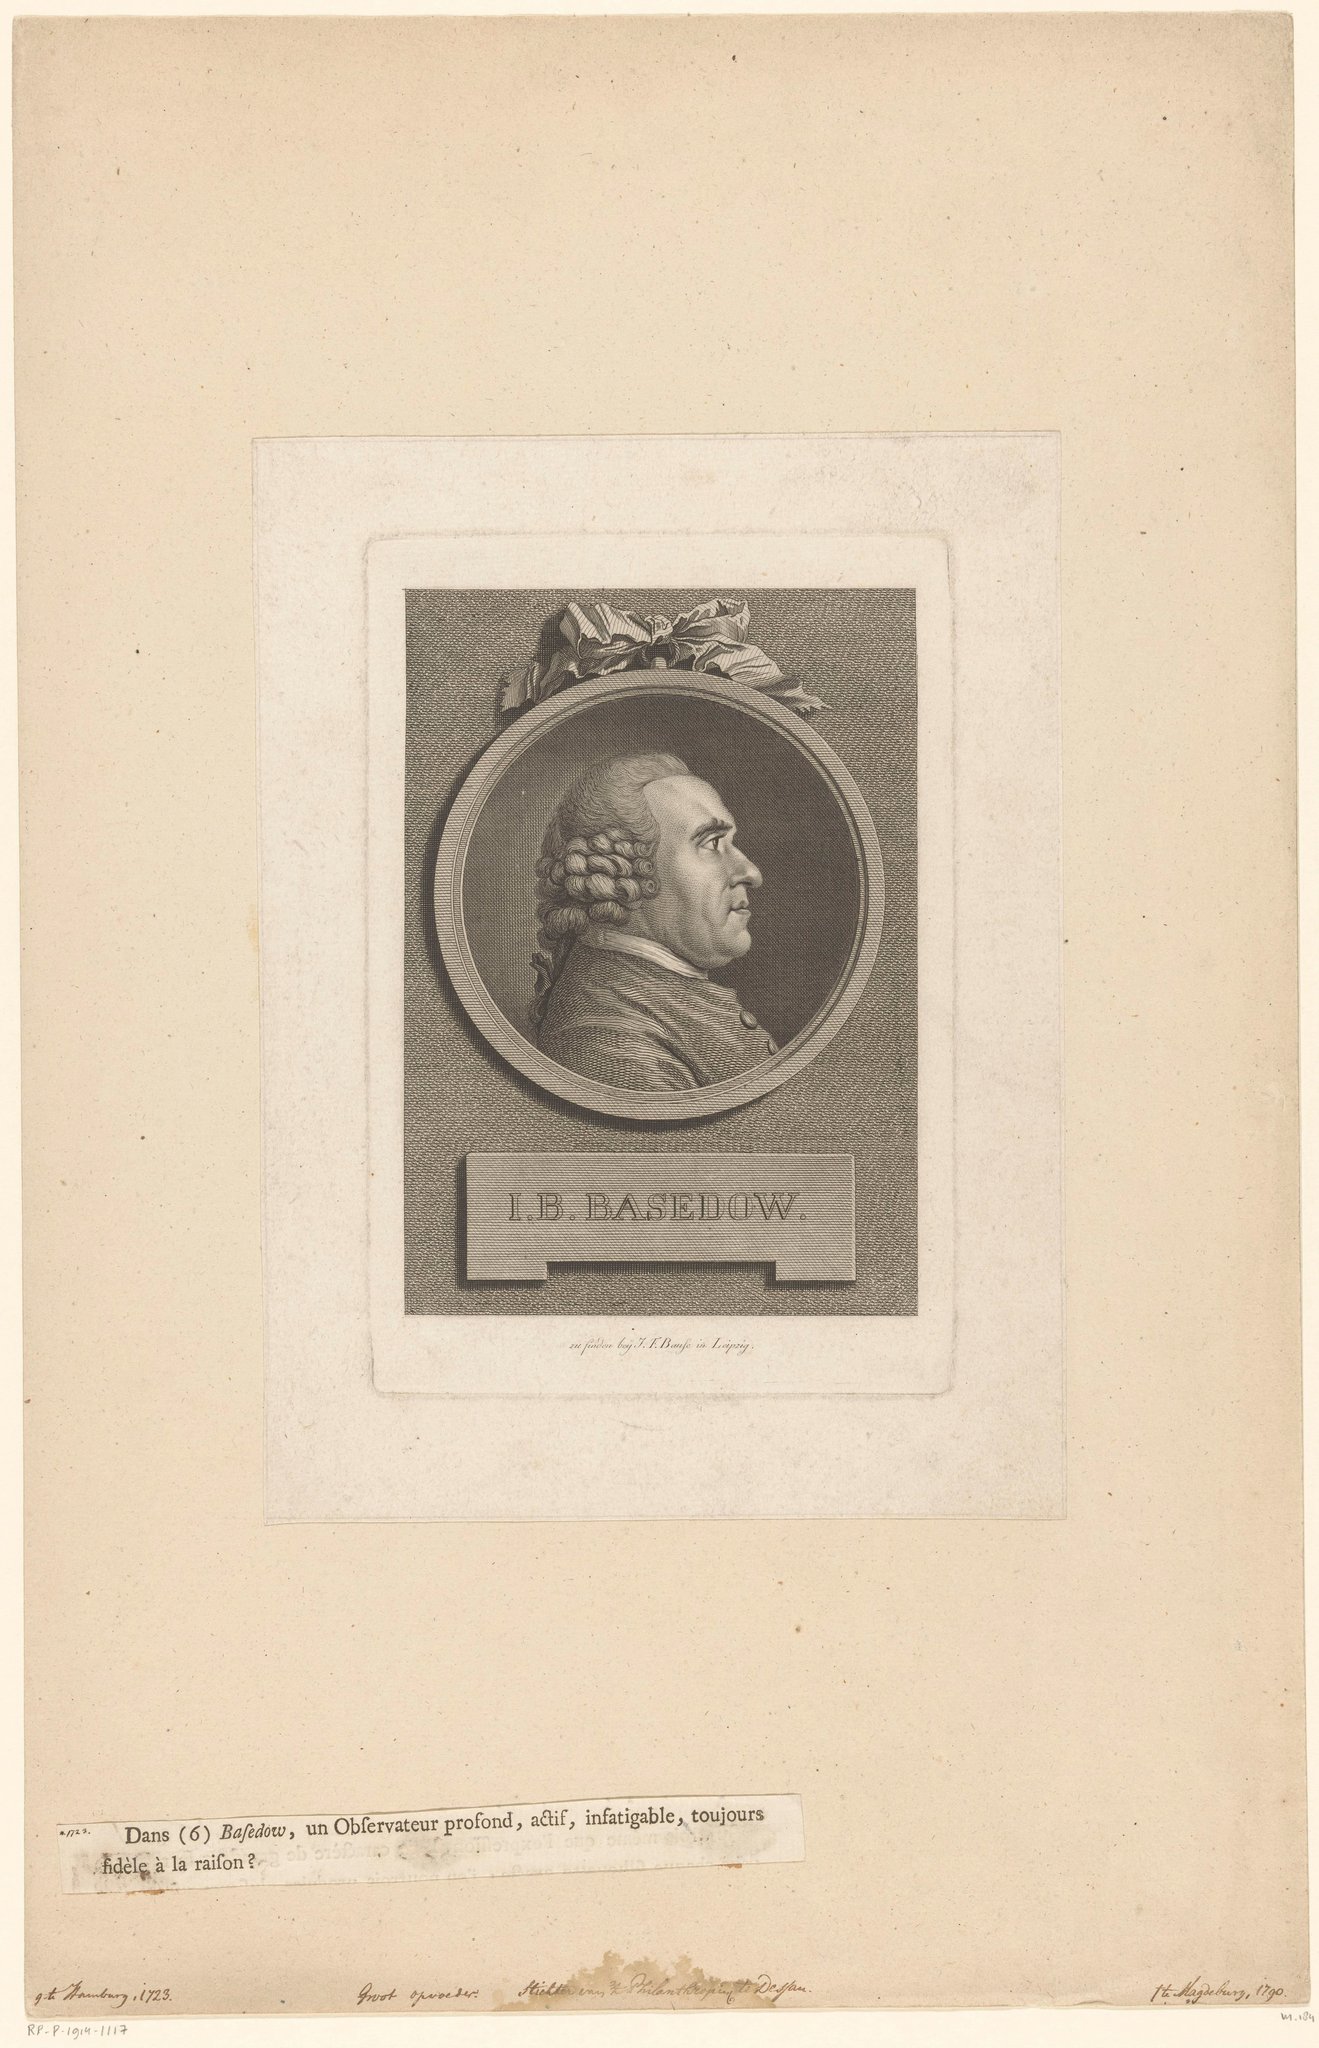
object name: print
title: Portret van Johann Bernhard Basedow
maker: johann friedrich bause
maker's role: draughtsman, print maker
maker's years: 1738-1814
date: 1769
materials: paper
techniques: engraving, etching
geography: leipzig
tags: johann bernhard basedow, historical persons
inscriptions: collector's mark: Lugt 2228